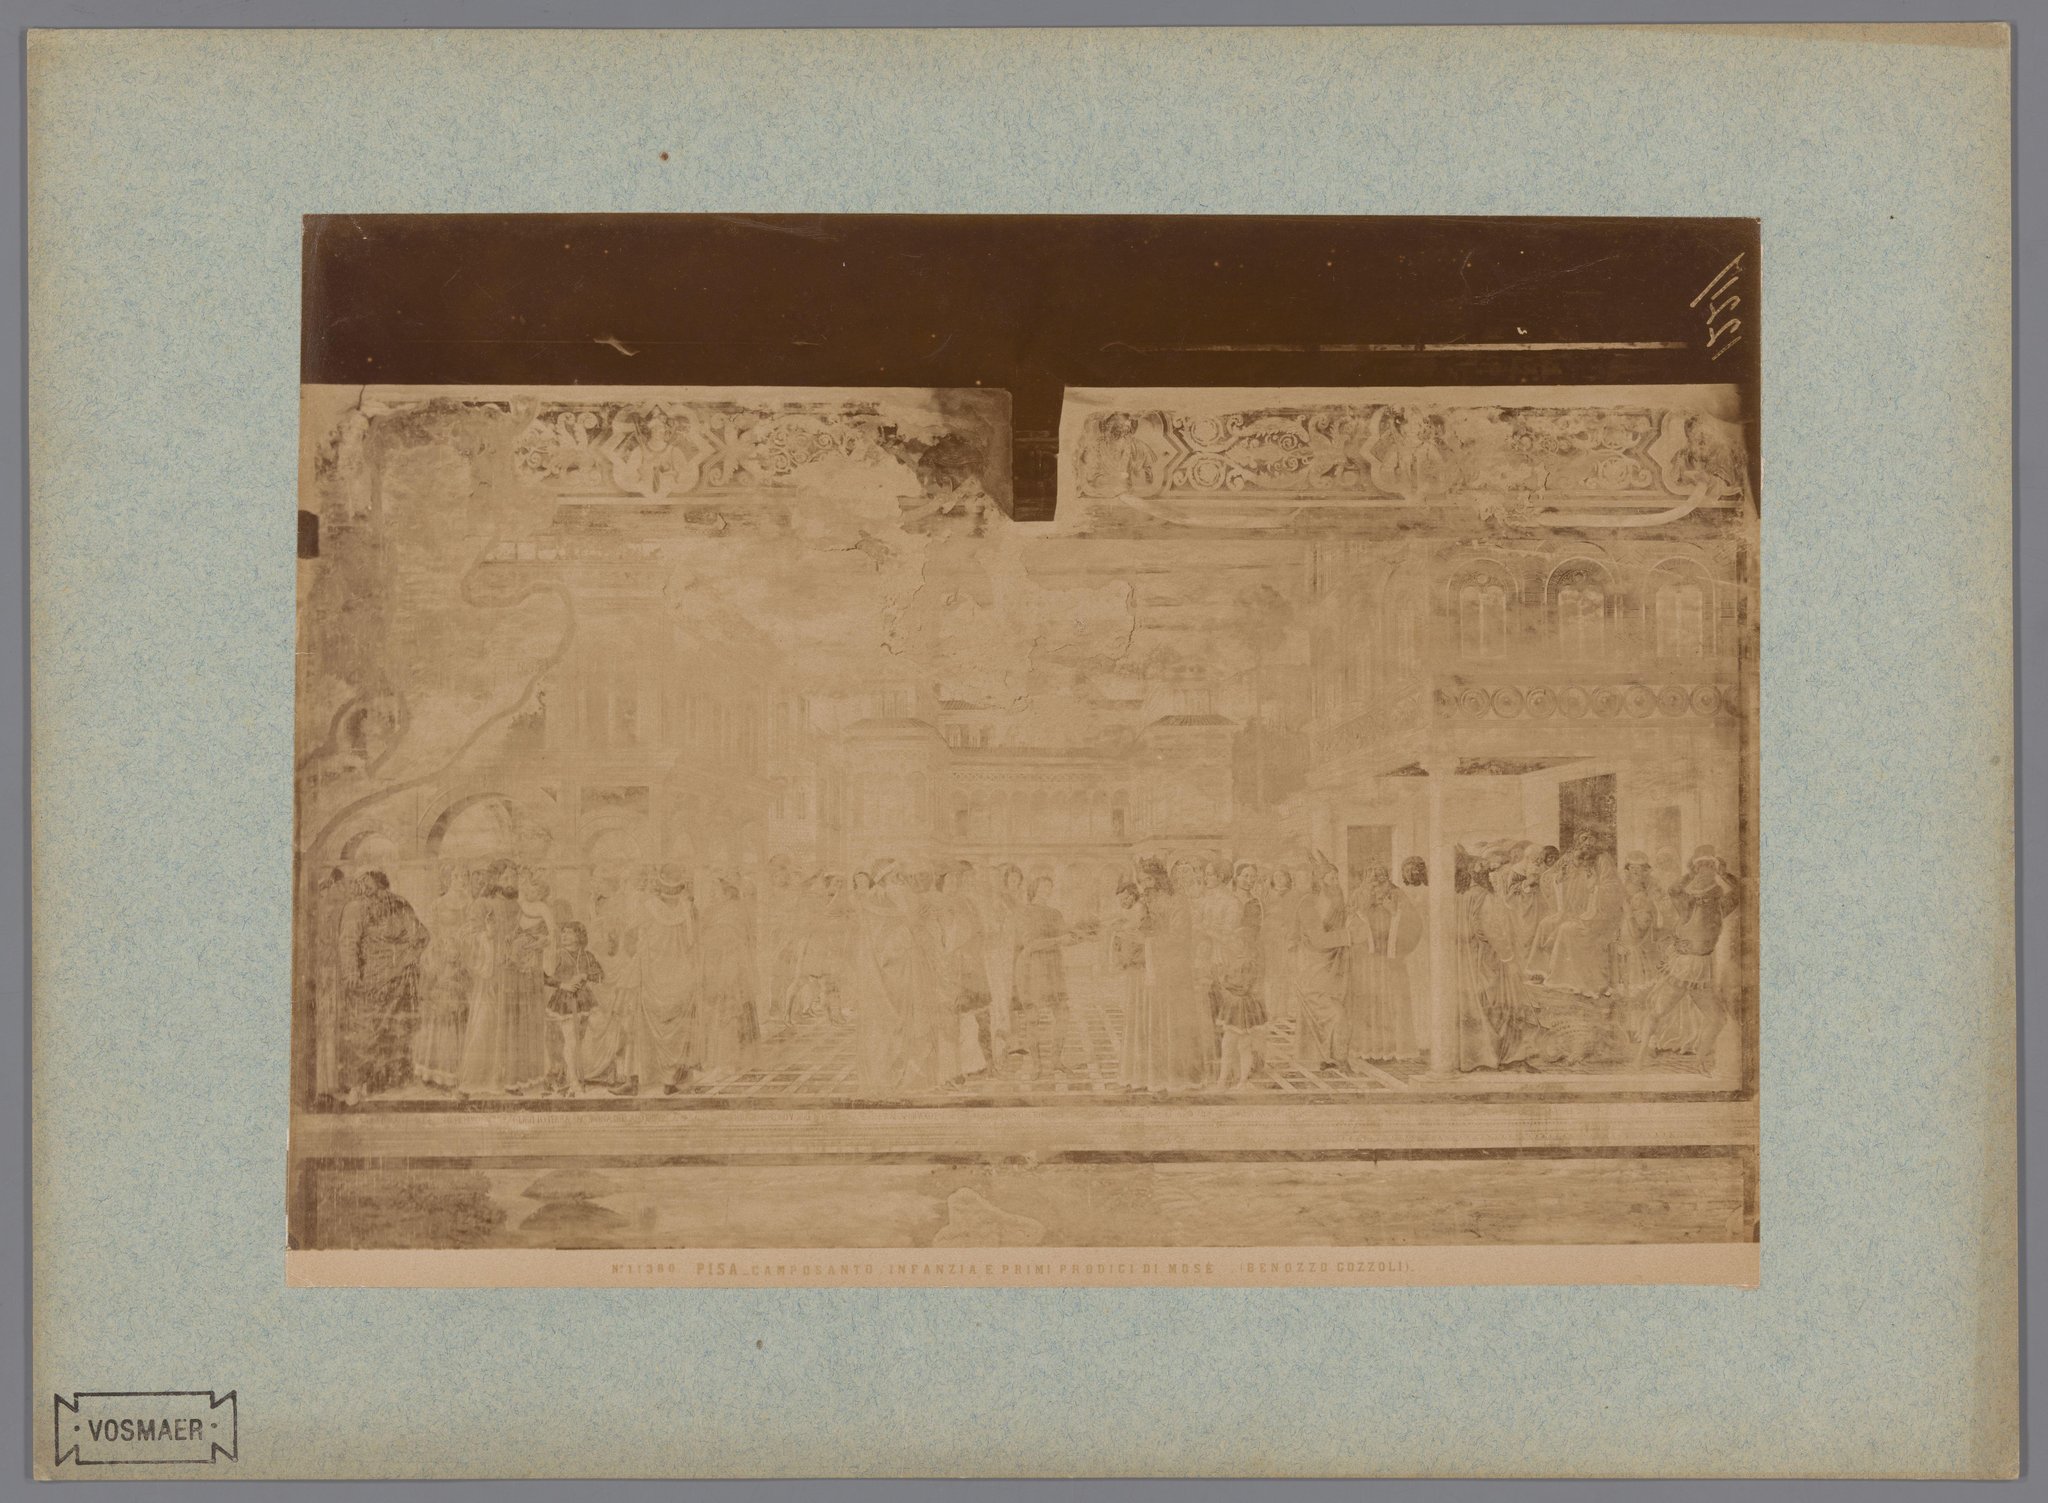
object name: photograph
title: Camposanto. Infanzia e primi prodigi di Mosè. (Benozzo Gozzoli)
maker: benozzo gozzoli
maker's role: draughtsman, painter, sculptor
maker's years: 1421-1497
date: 1857-1900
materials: cardboard, paper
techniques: albumen print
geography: florence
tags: picture, painting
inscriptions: number: ‘No. 11380’, collector's mark: ‘VOSMAER’